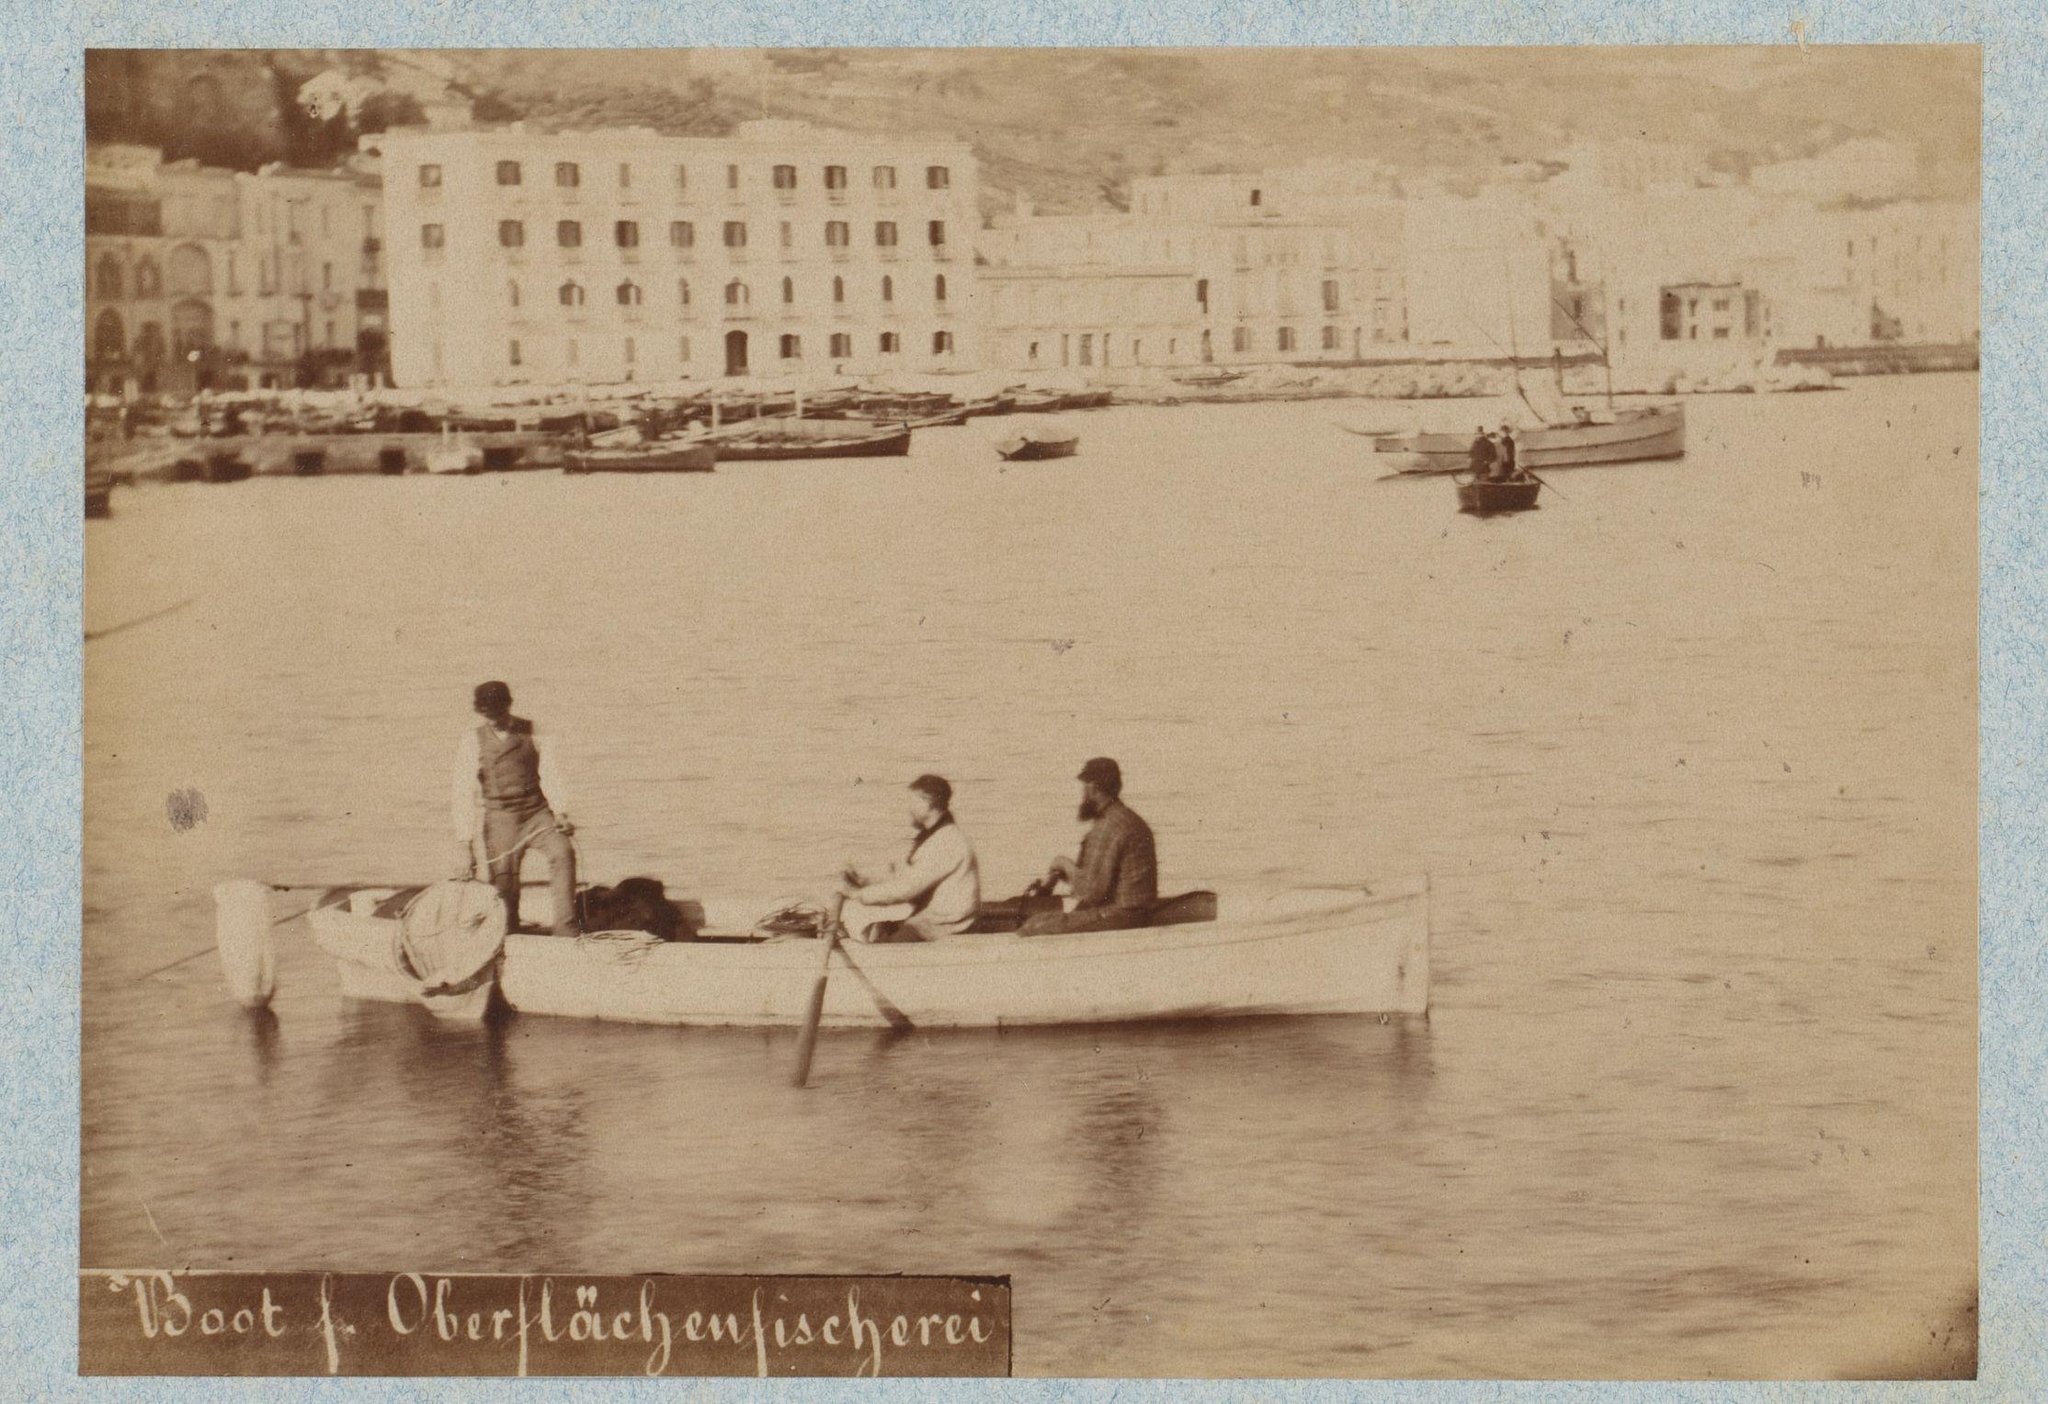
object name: photograph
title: Boot f. Oberfläherfischerei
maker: Anonymous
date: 1872-1900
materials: cardboard, paper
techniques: albumen print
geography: naples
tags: fishing net, rowing facing backward, pulling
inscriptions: collector's mark: ‘VOSMAER’